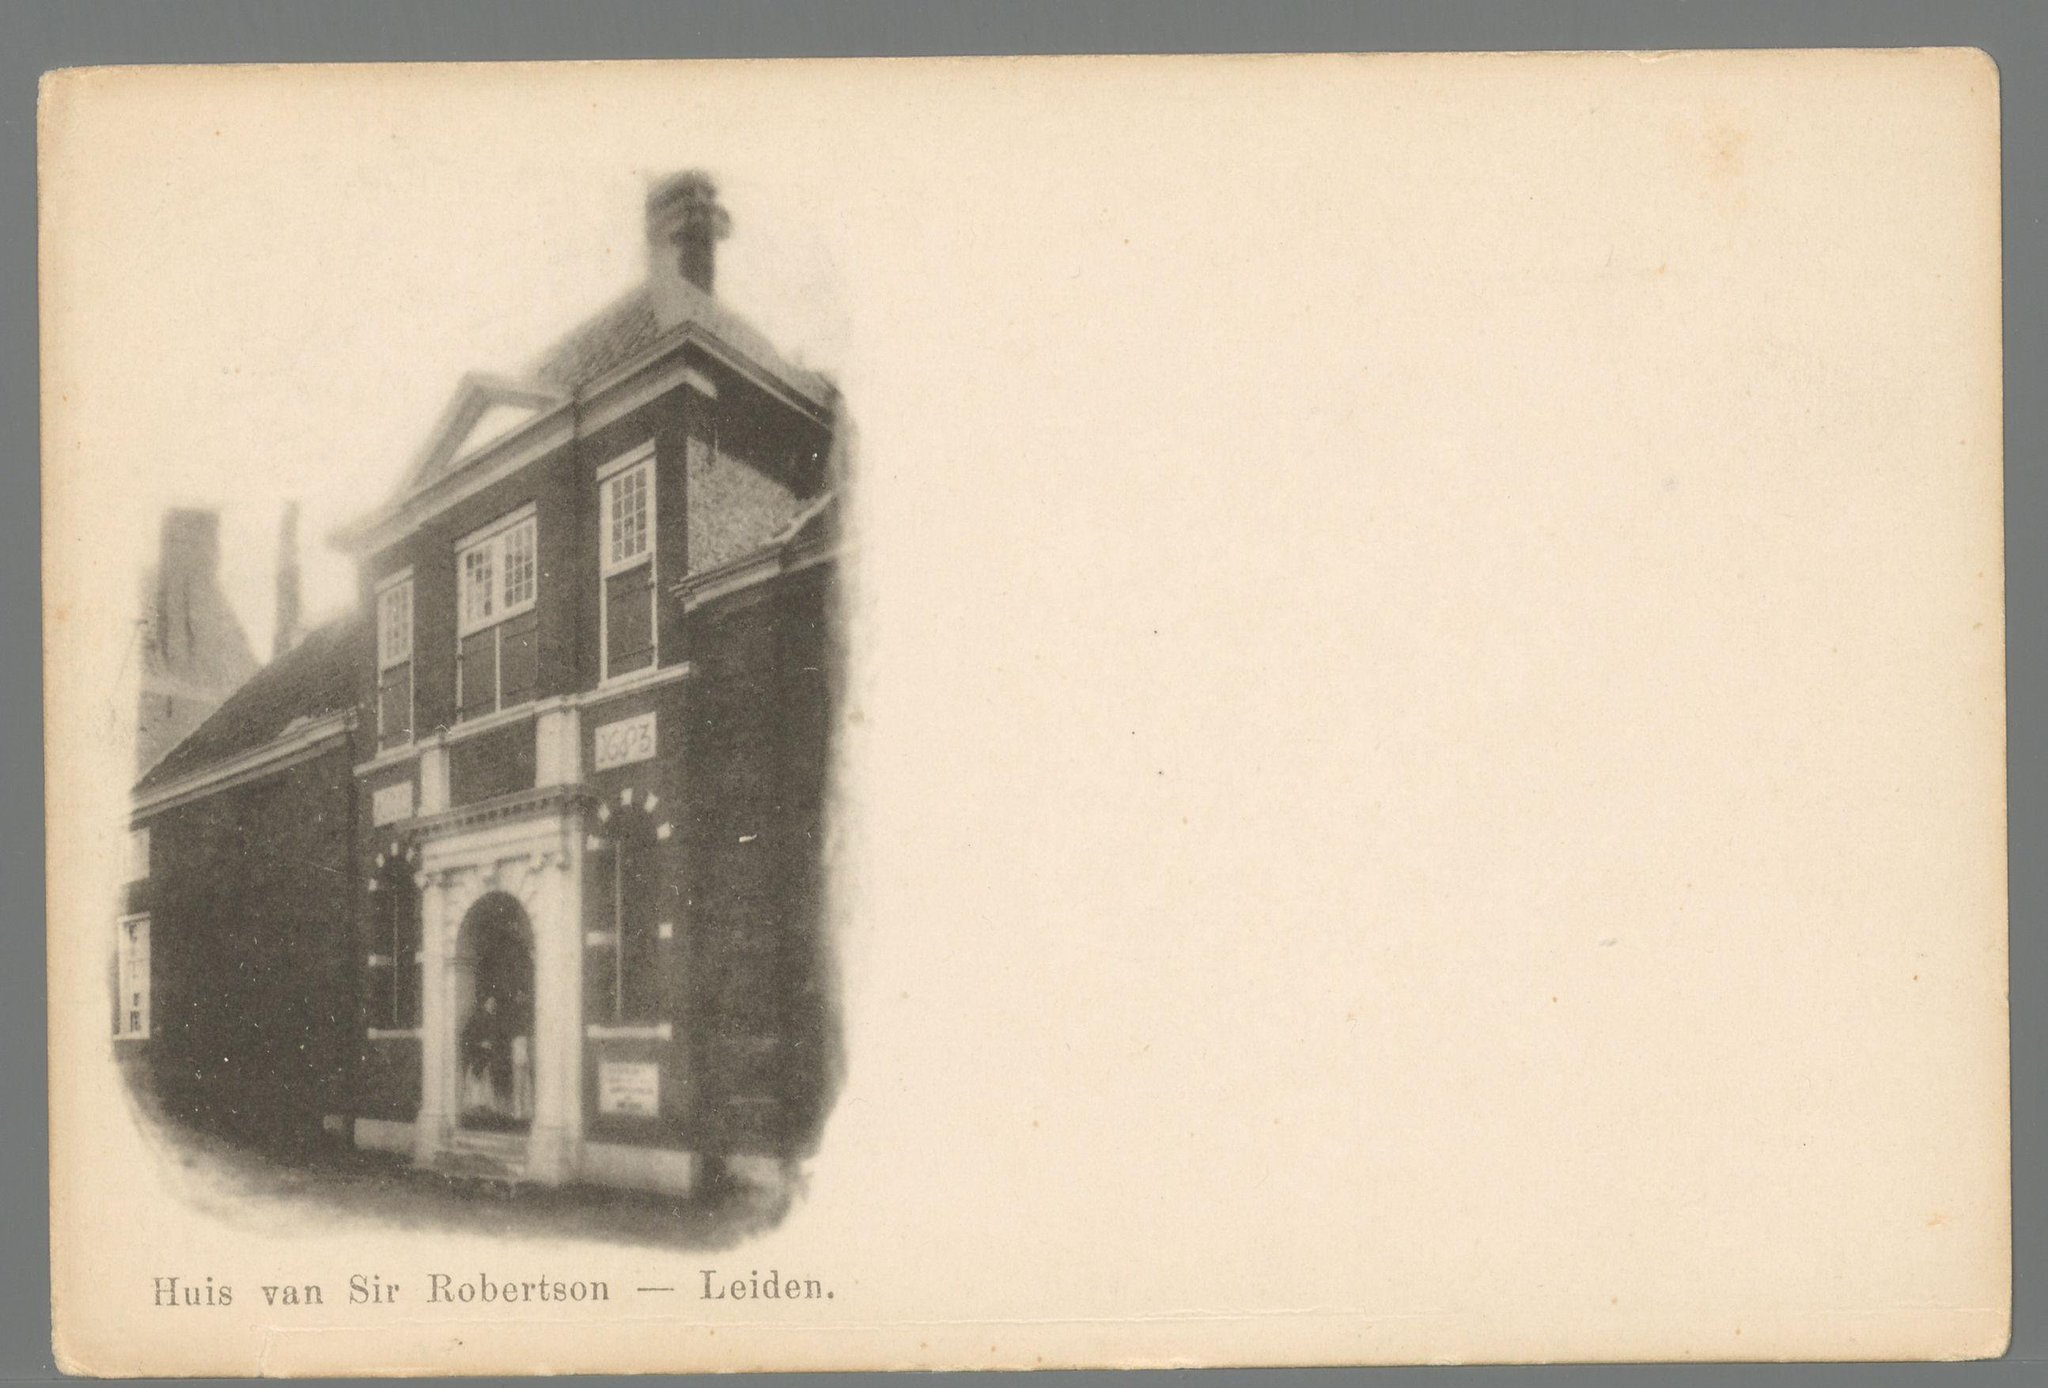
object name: ansichtkaart, prentbriefkaart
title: Huis van Sir Robertson - Leiden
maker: Anonymous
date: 1895-1901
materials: cardboard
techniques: photograph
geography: leiden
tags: alms-house (dutch: 'hofje'), gate, entrance